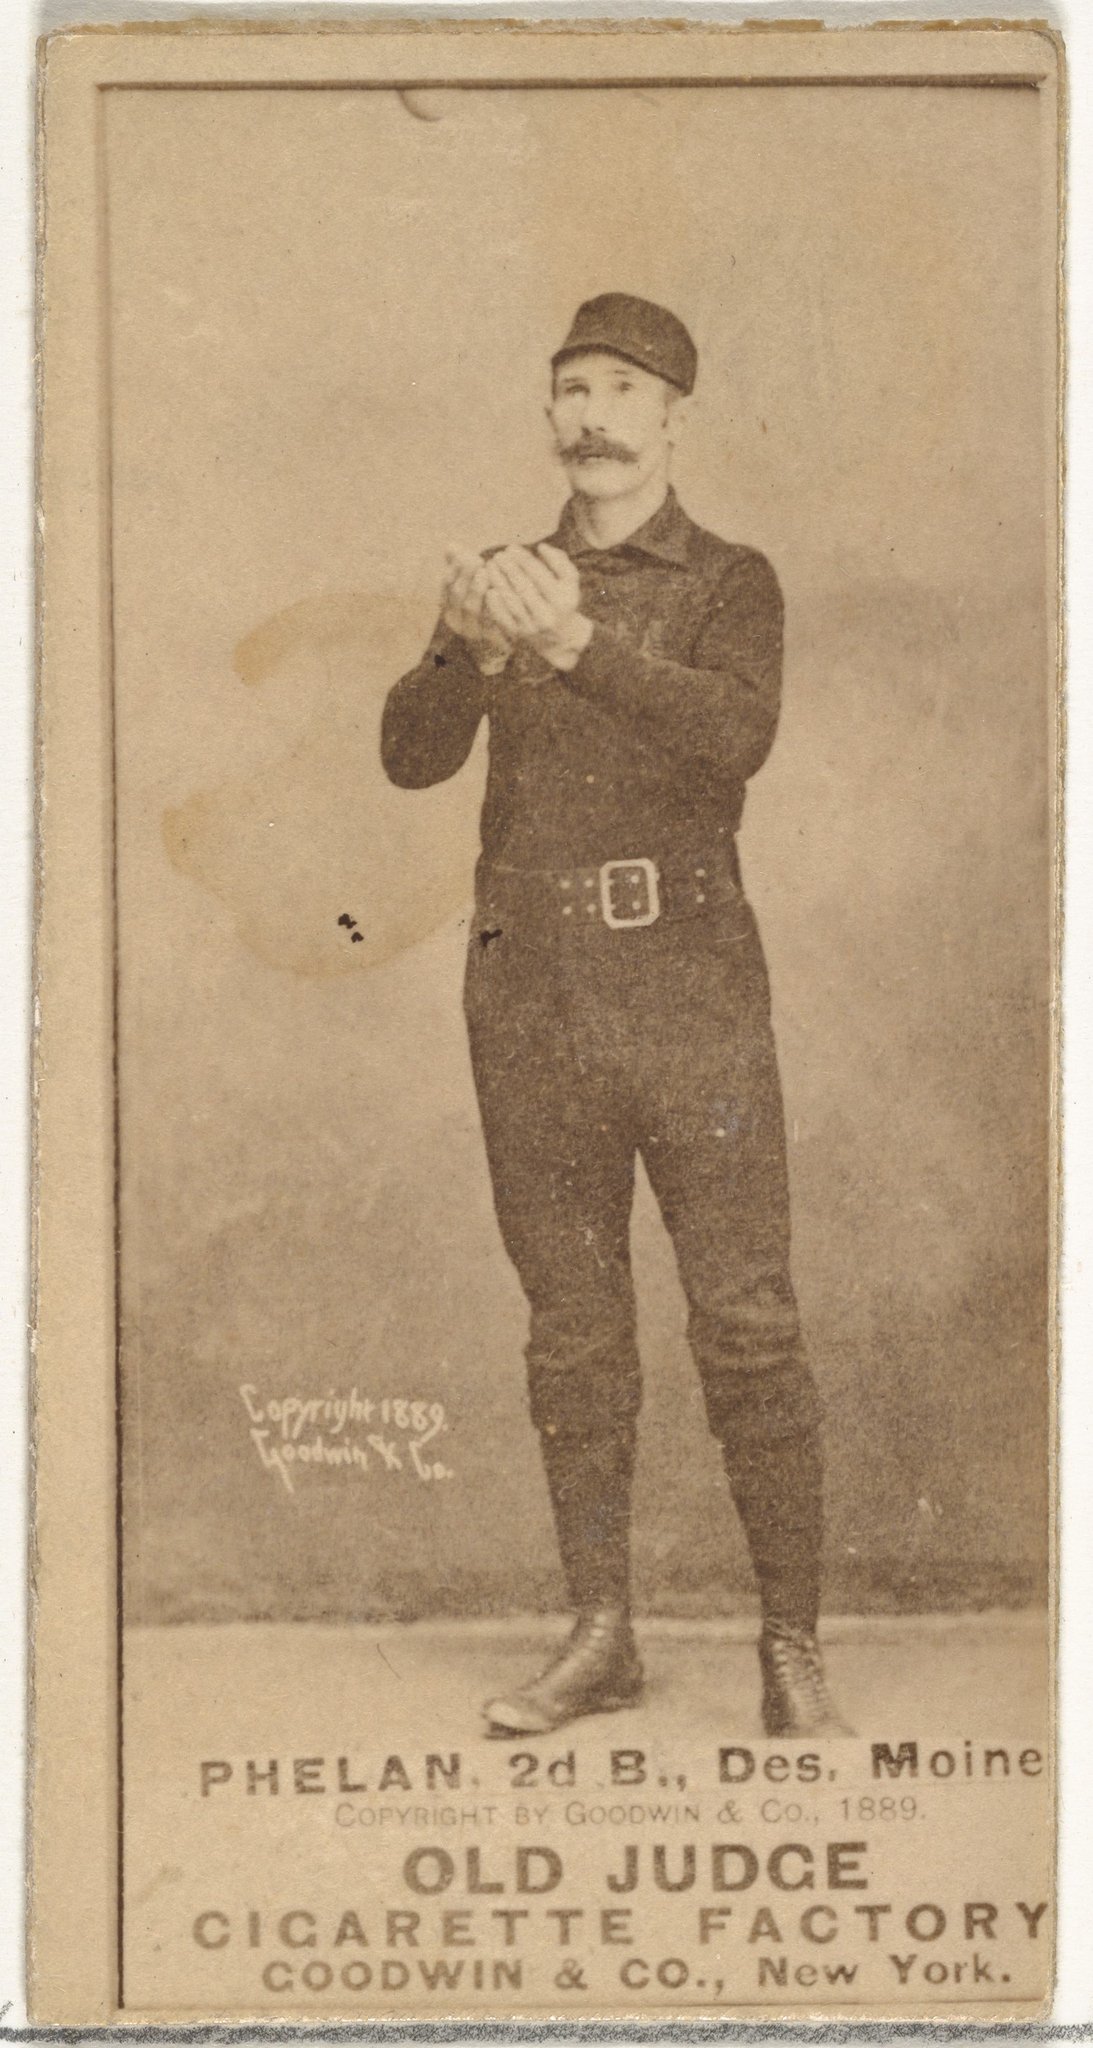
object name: baseball card, photograph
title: James Dickson "Dick" Phelan, 2nd Base, Des Moines Prohibitionists, from the Old Judge series (N172) for Old Judge Cigarettes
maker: goodwin & company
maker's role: publisher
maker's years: 1850-1950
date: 1889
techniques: albumen silver print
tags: men,portraits,baseball,athletes